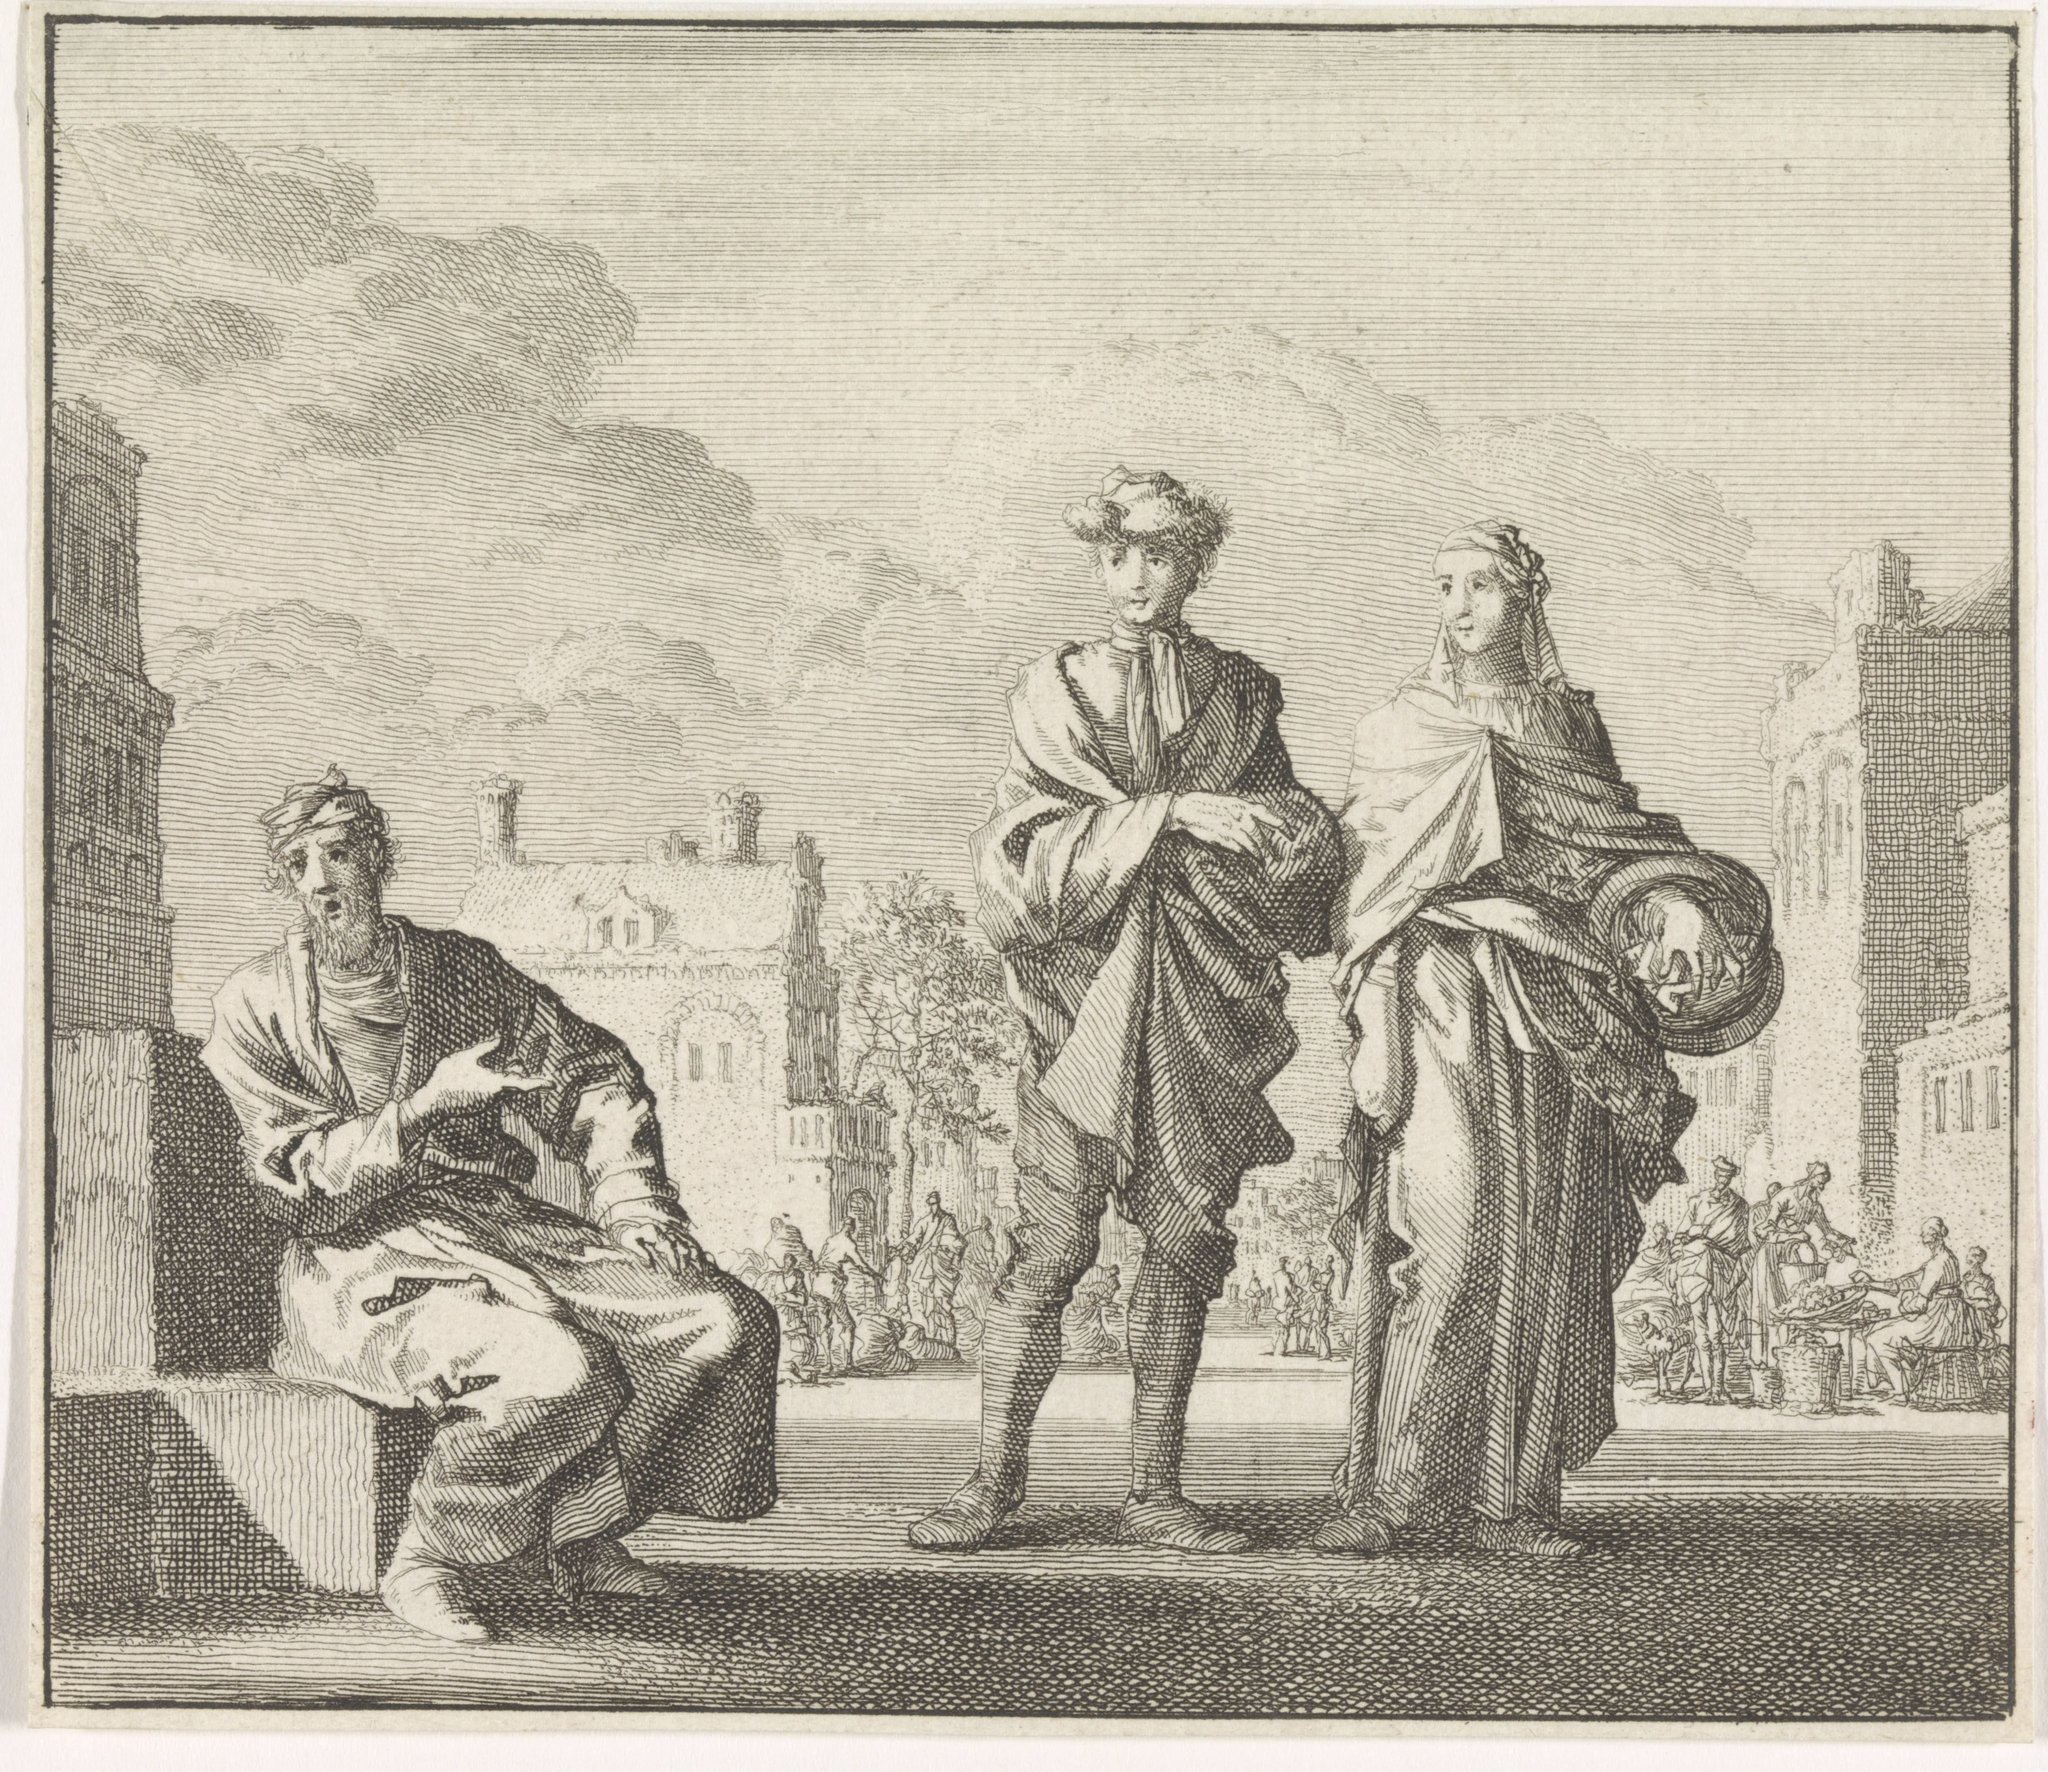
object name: book illustration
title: Embleem: mens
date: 1695-1705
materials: paper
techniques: etching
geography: amsterdam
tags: birthday, old man, street, index finger forwards, pointing, indicating, abstract ideas and concepts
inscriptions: collector's mark: Lugt 240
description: Boekillustratie voor Weigel, Christoph. Ethica Naturalis seu Documenta Moralia e Variis rerum Naturalium proprietatibus Virtutum Vitiorumq symbolicis imaginibus collecta. Neurenberg: Christoph Weigel: c. 1700.